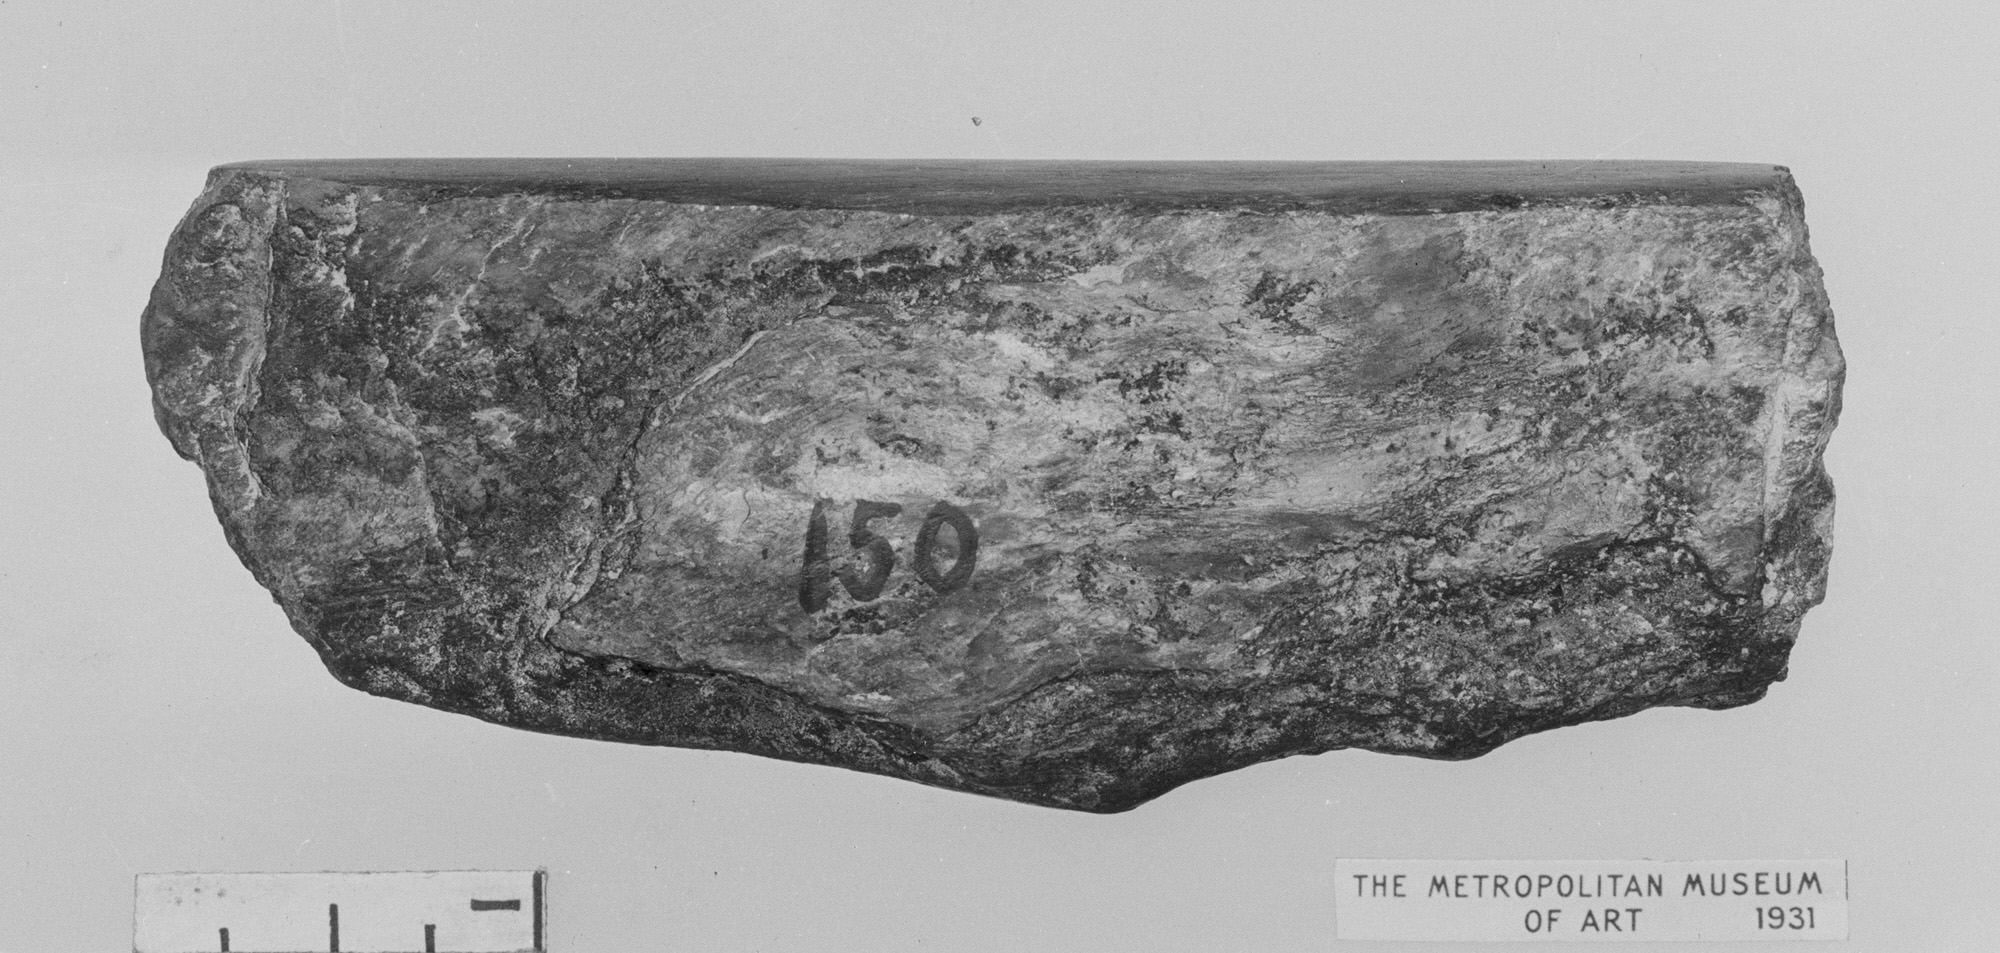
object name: fragment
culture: swiss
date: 1902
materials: jade